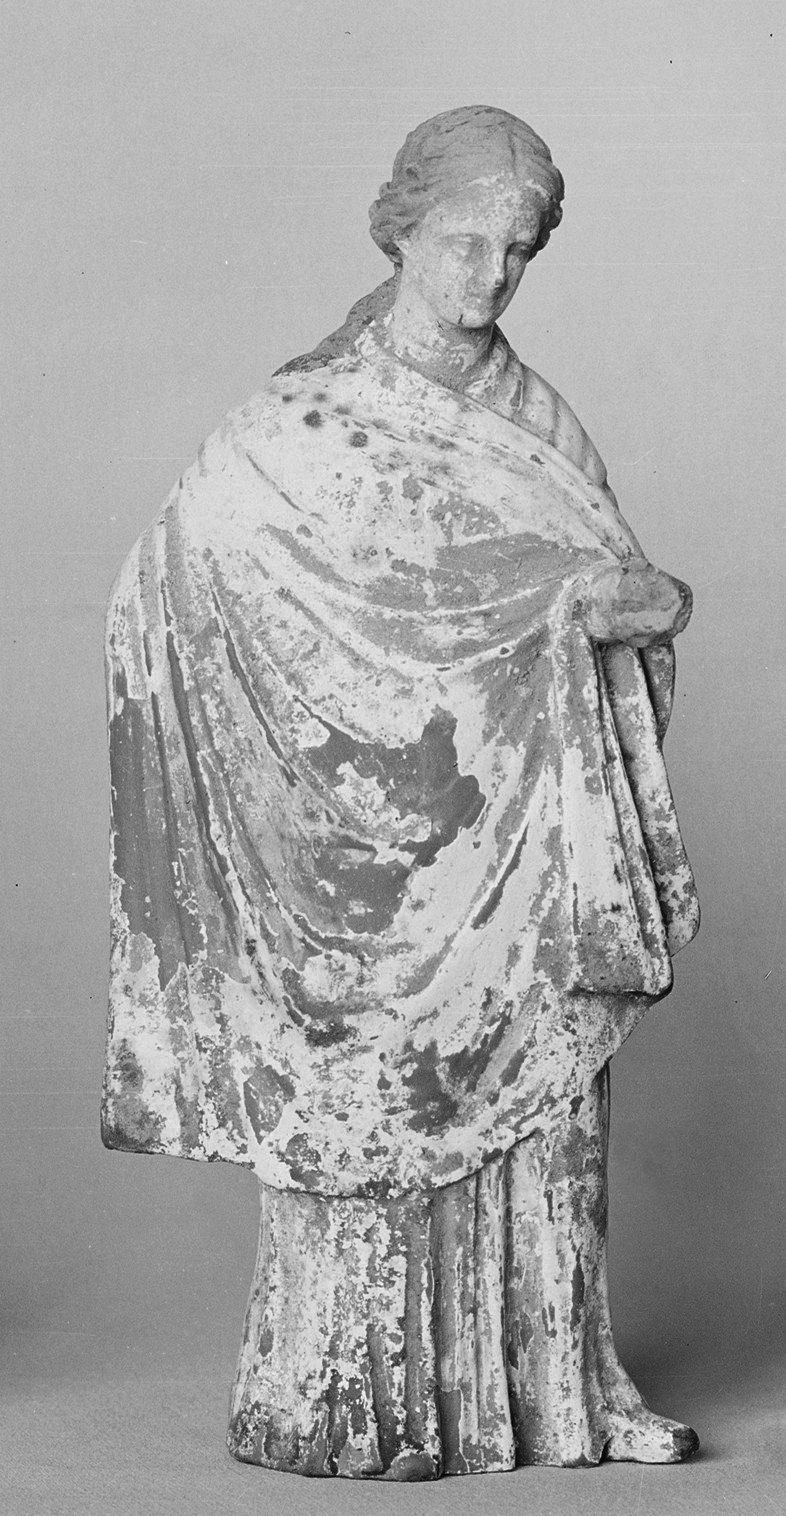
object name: statuette of a woman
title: Terracotta statuette of a woman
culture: greek, corinthian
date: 400-301 BCE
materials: terracotta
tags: women